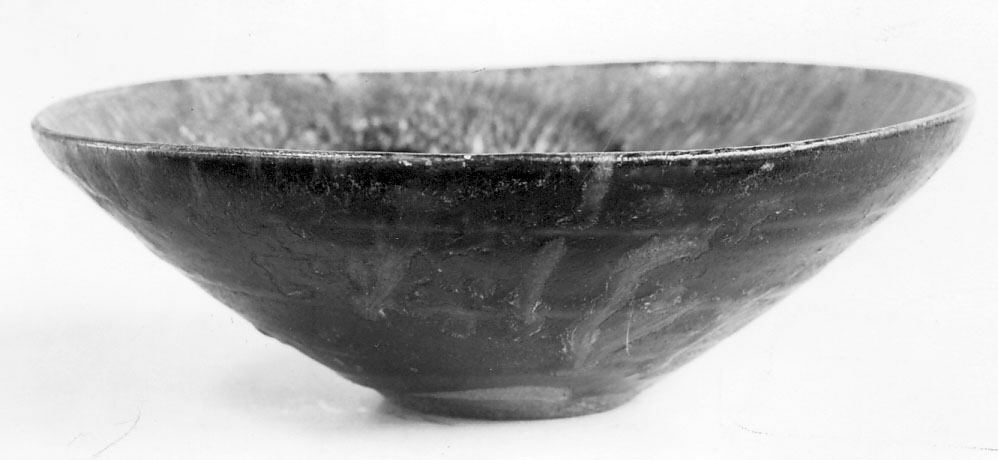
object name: bowl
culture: chinese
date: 960-1279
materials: pottery